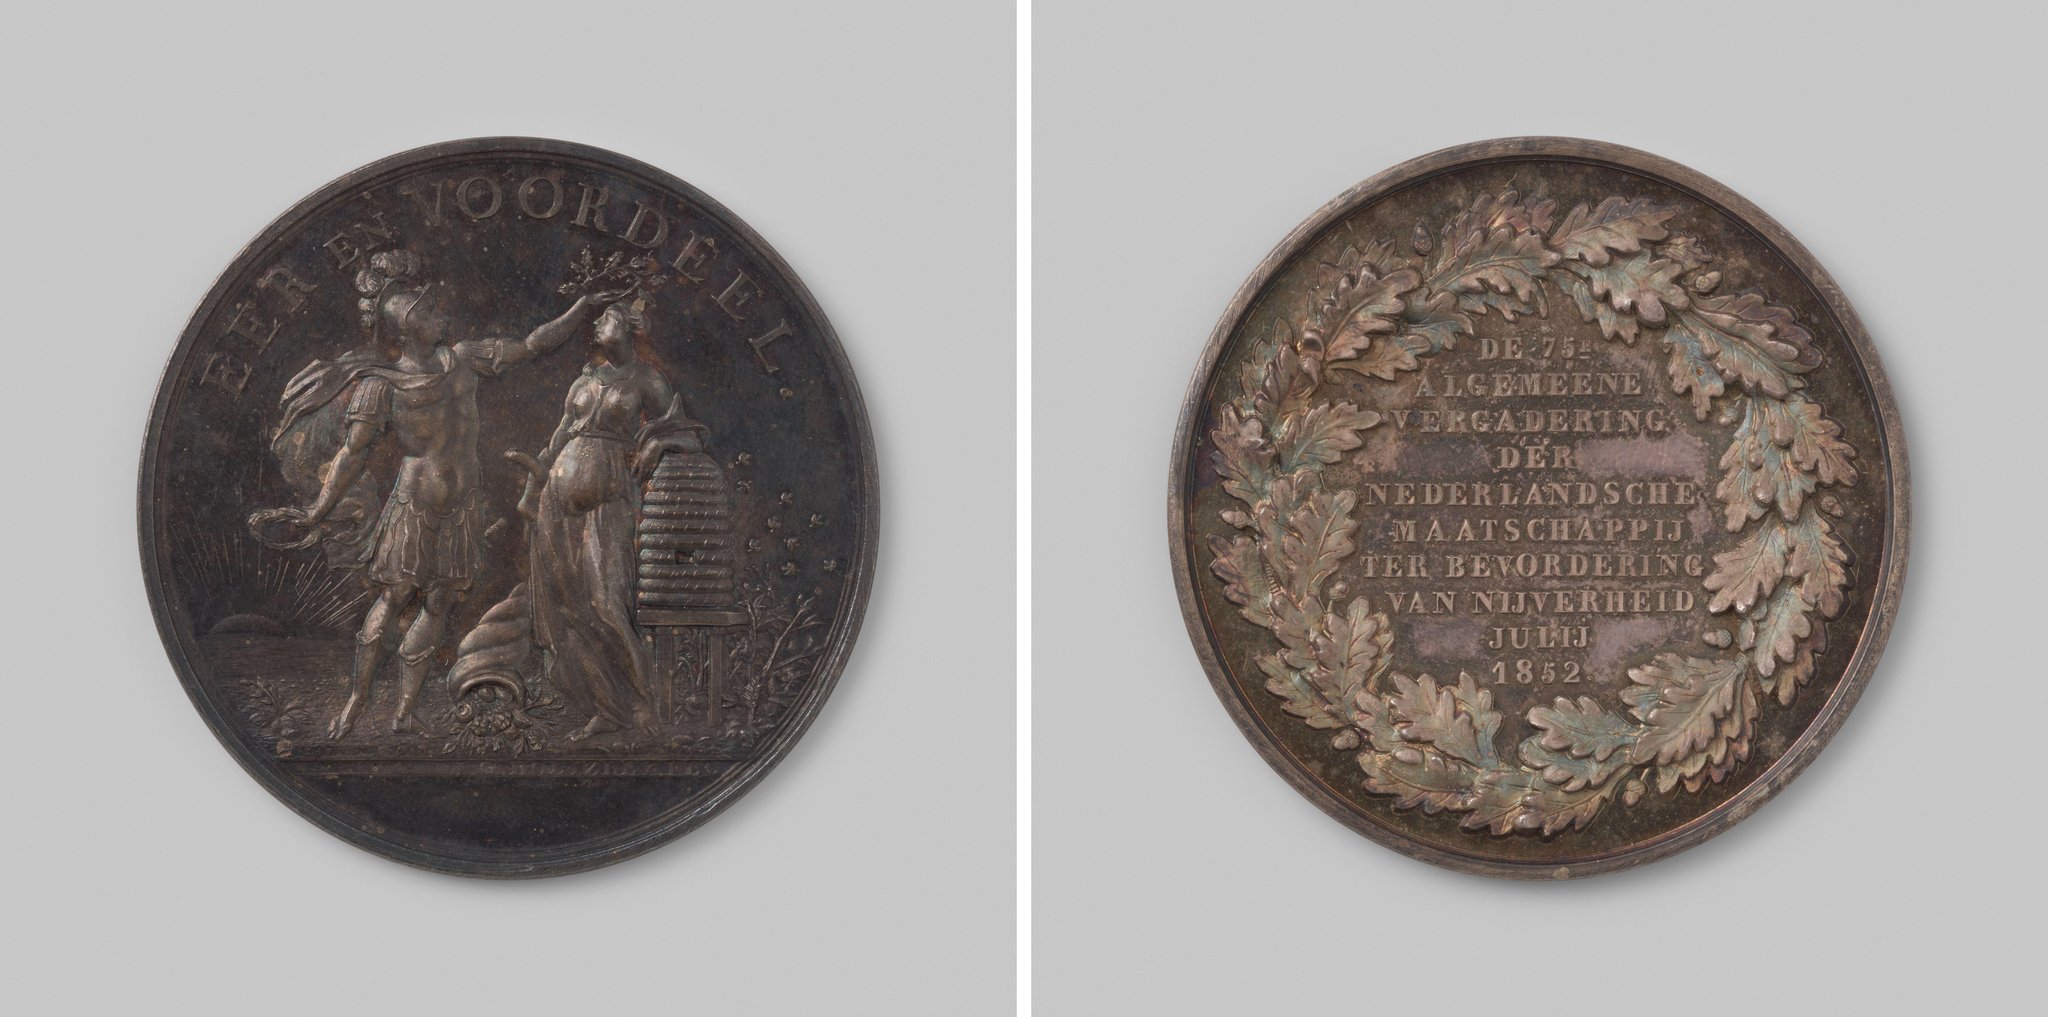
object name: history medal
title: Vijfenzeventigste algemene vergadering der Nederlandse Maatschappij ter bevordering van Nijverheid, voorheen de Oeconomische Tak van de Hollandsche Maatschappij der Wetenschappen te Haarlem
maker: johan george holtzhey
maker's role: mintmaster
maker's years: 1726-1808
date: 1852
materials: silver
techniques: striking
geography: amsterdam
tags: haarlem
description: Zilveren penning. Voorzijde: man in Romeinse kledij, voorstellende Vaderlandsliefde, houdt in zijn rechterhand een lauwerkrans en zet met zijn andere hand eikenkrans op hoofd van Nijverheid, die hoorn van overvloed in handen houdt en tegen bijenkorf leunt; op achtergrond opgaande zon binnen omschrift. Keerzijde: opschrift binnen eikekrans